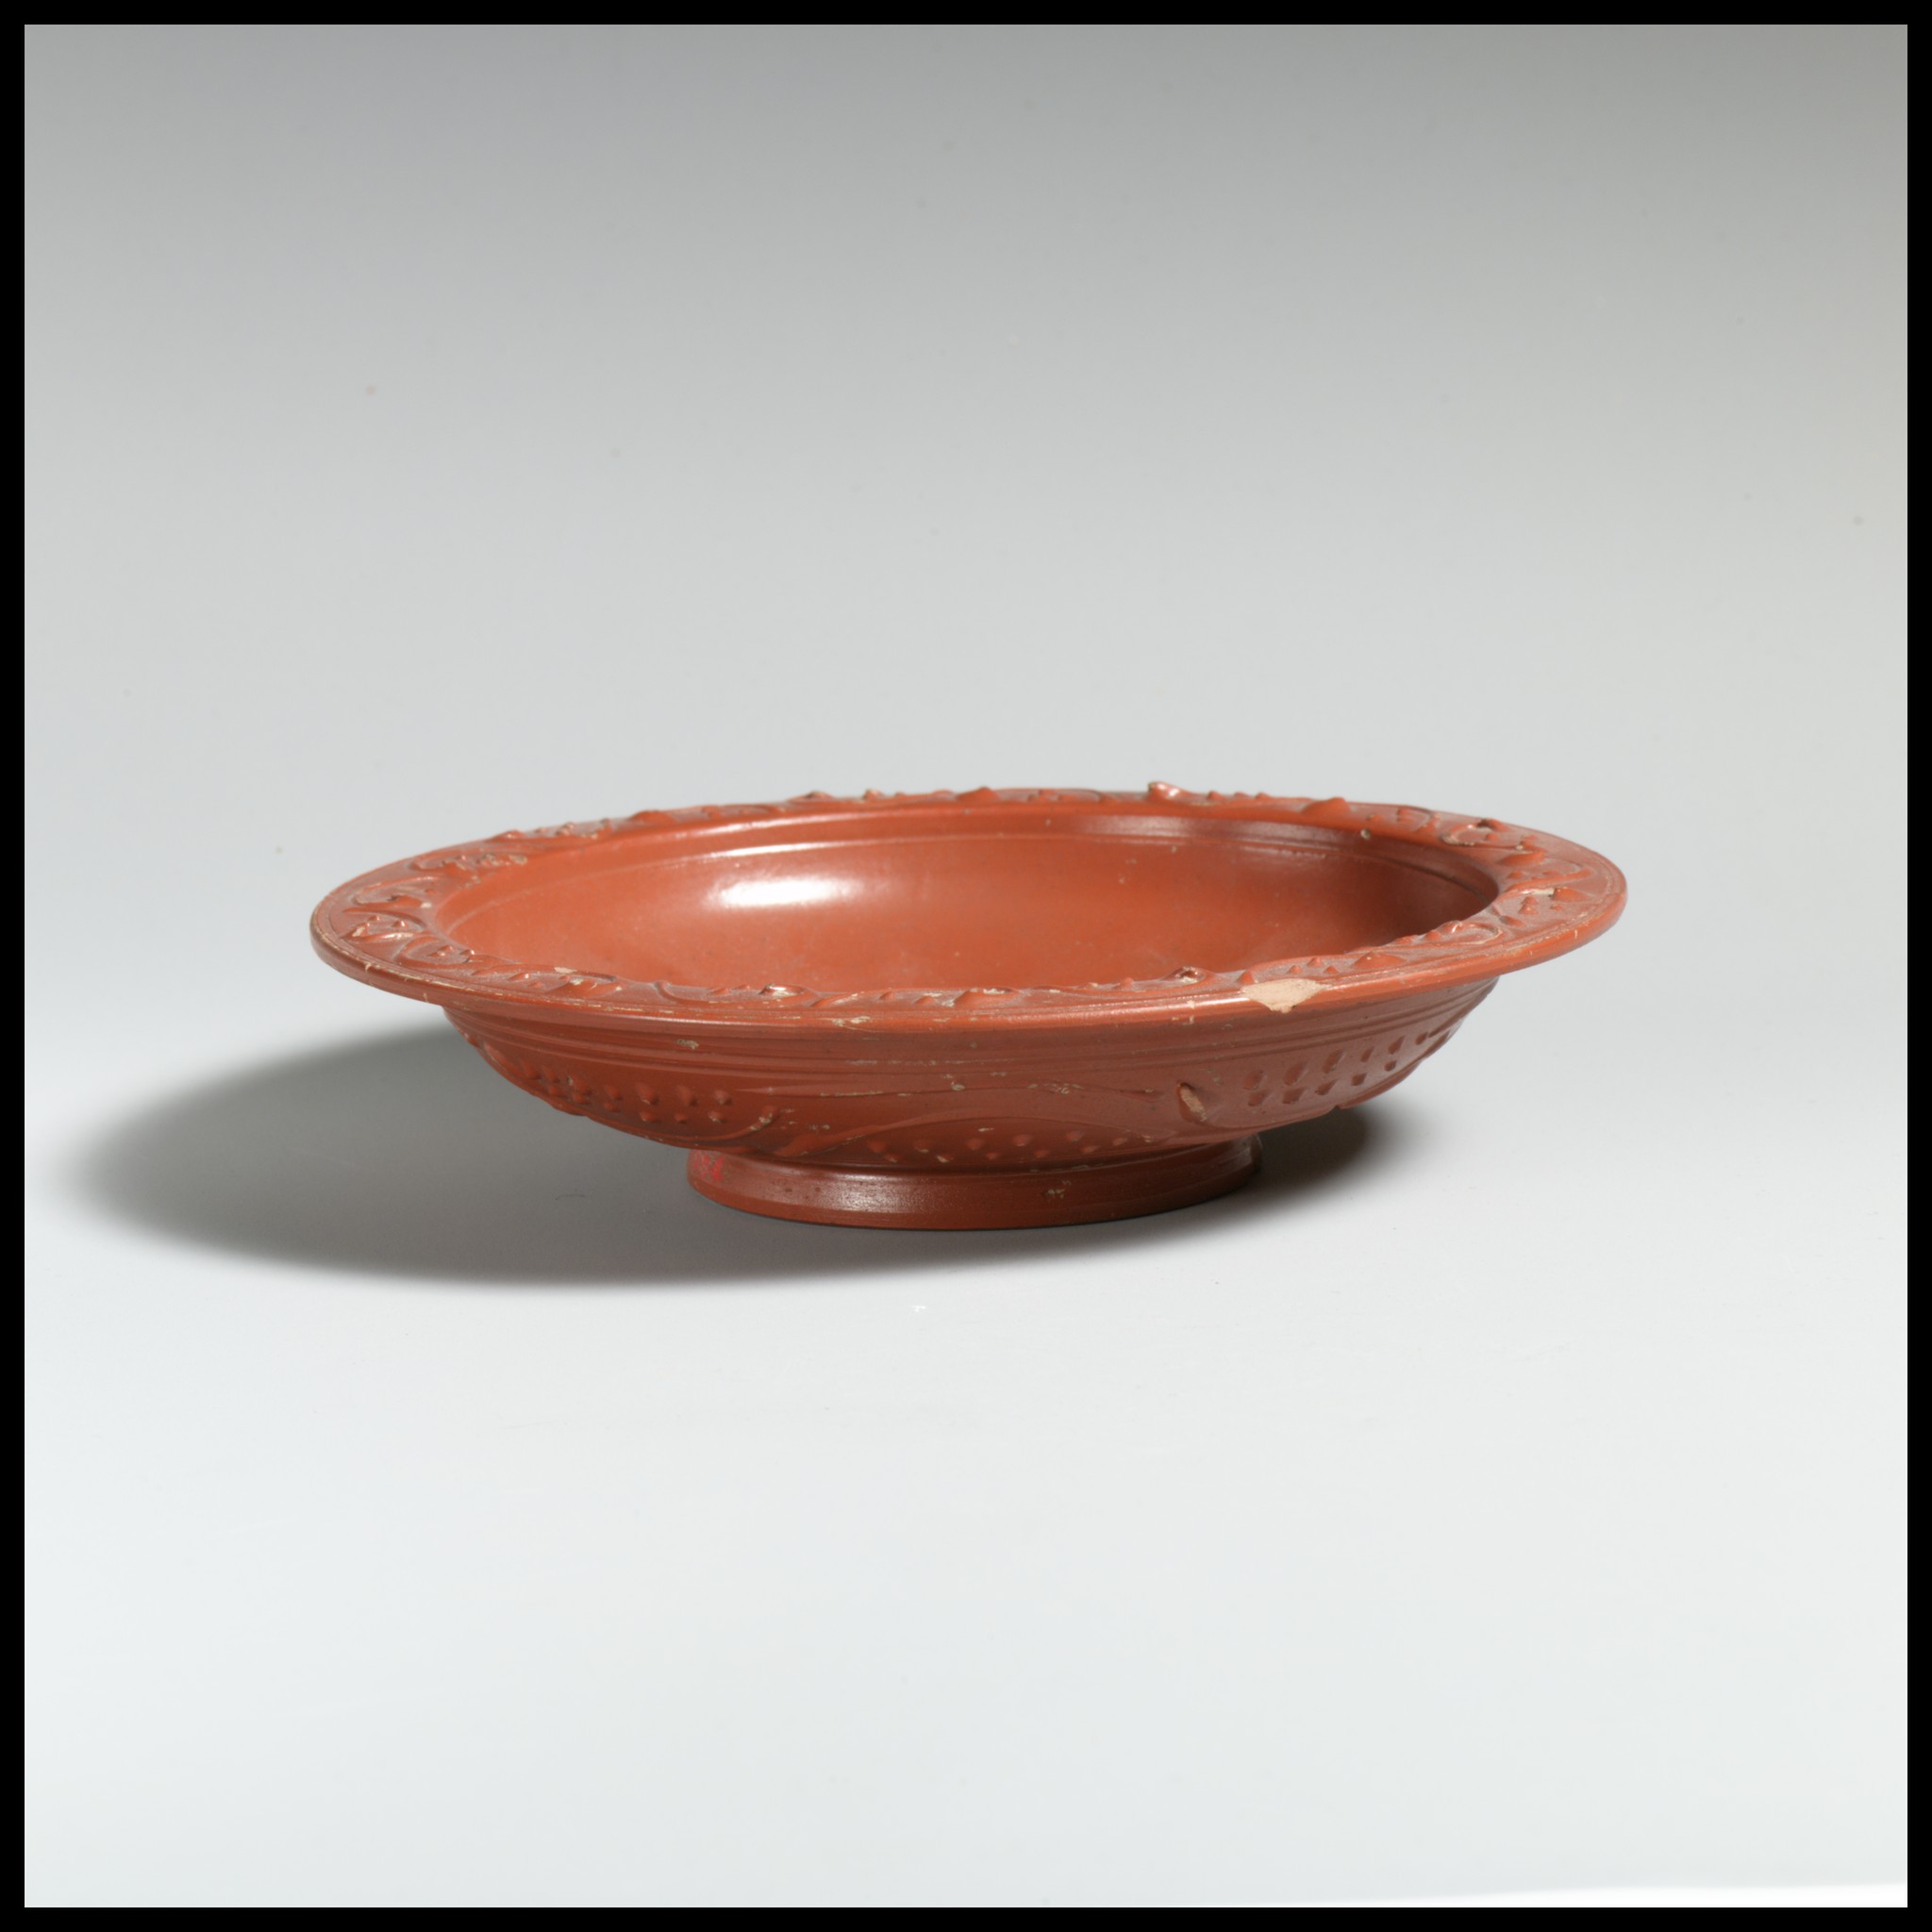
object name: bowl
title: Terracotta bowl with barbotine decoration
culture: roman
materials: terracotta